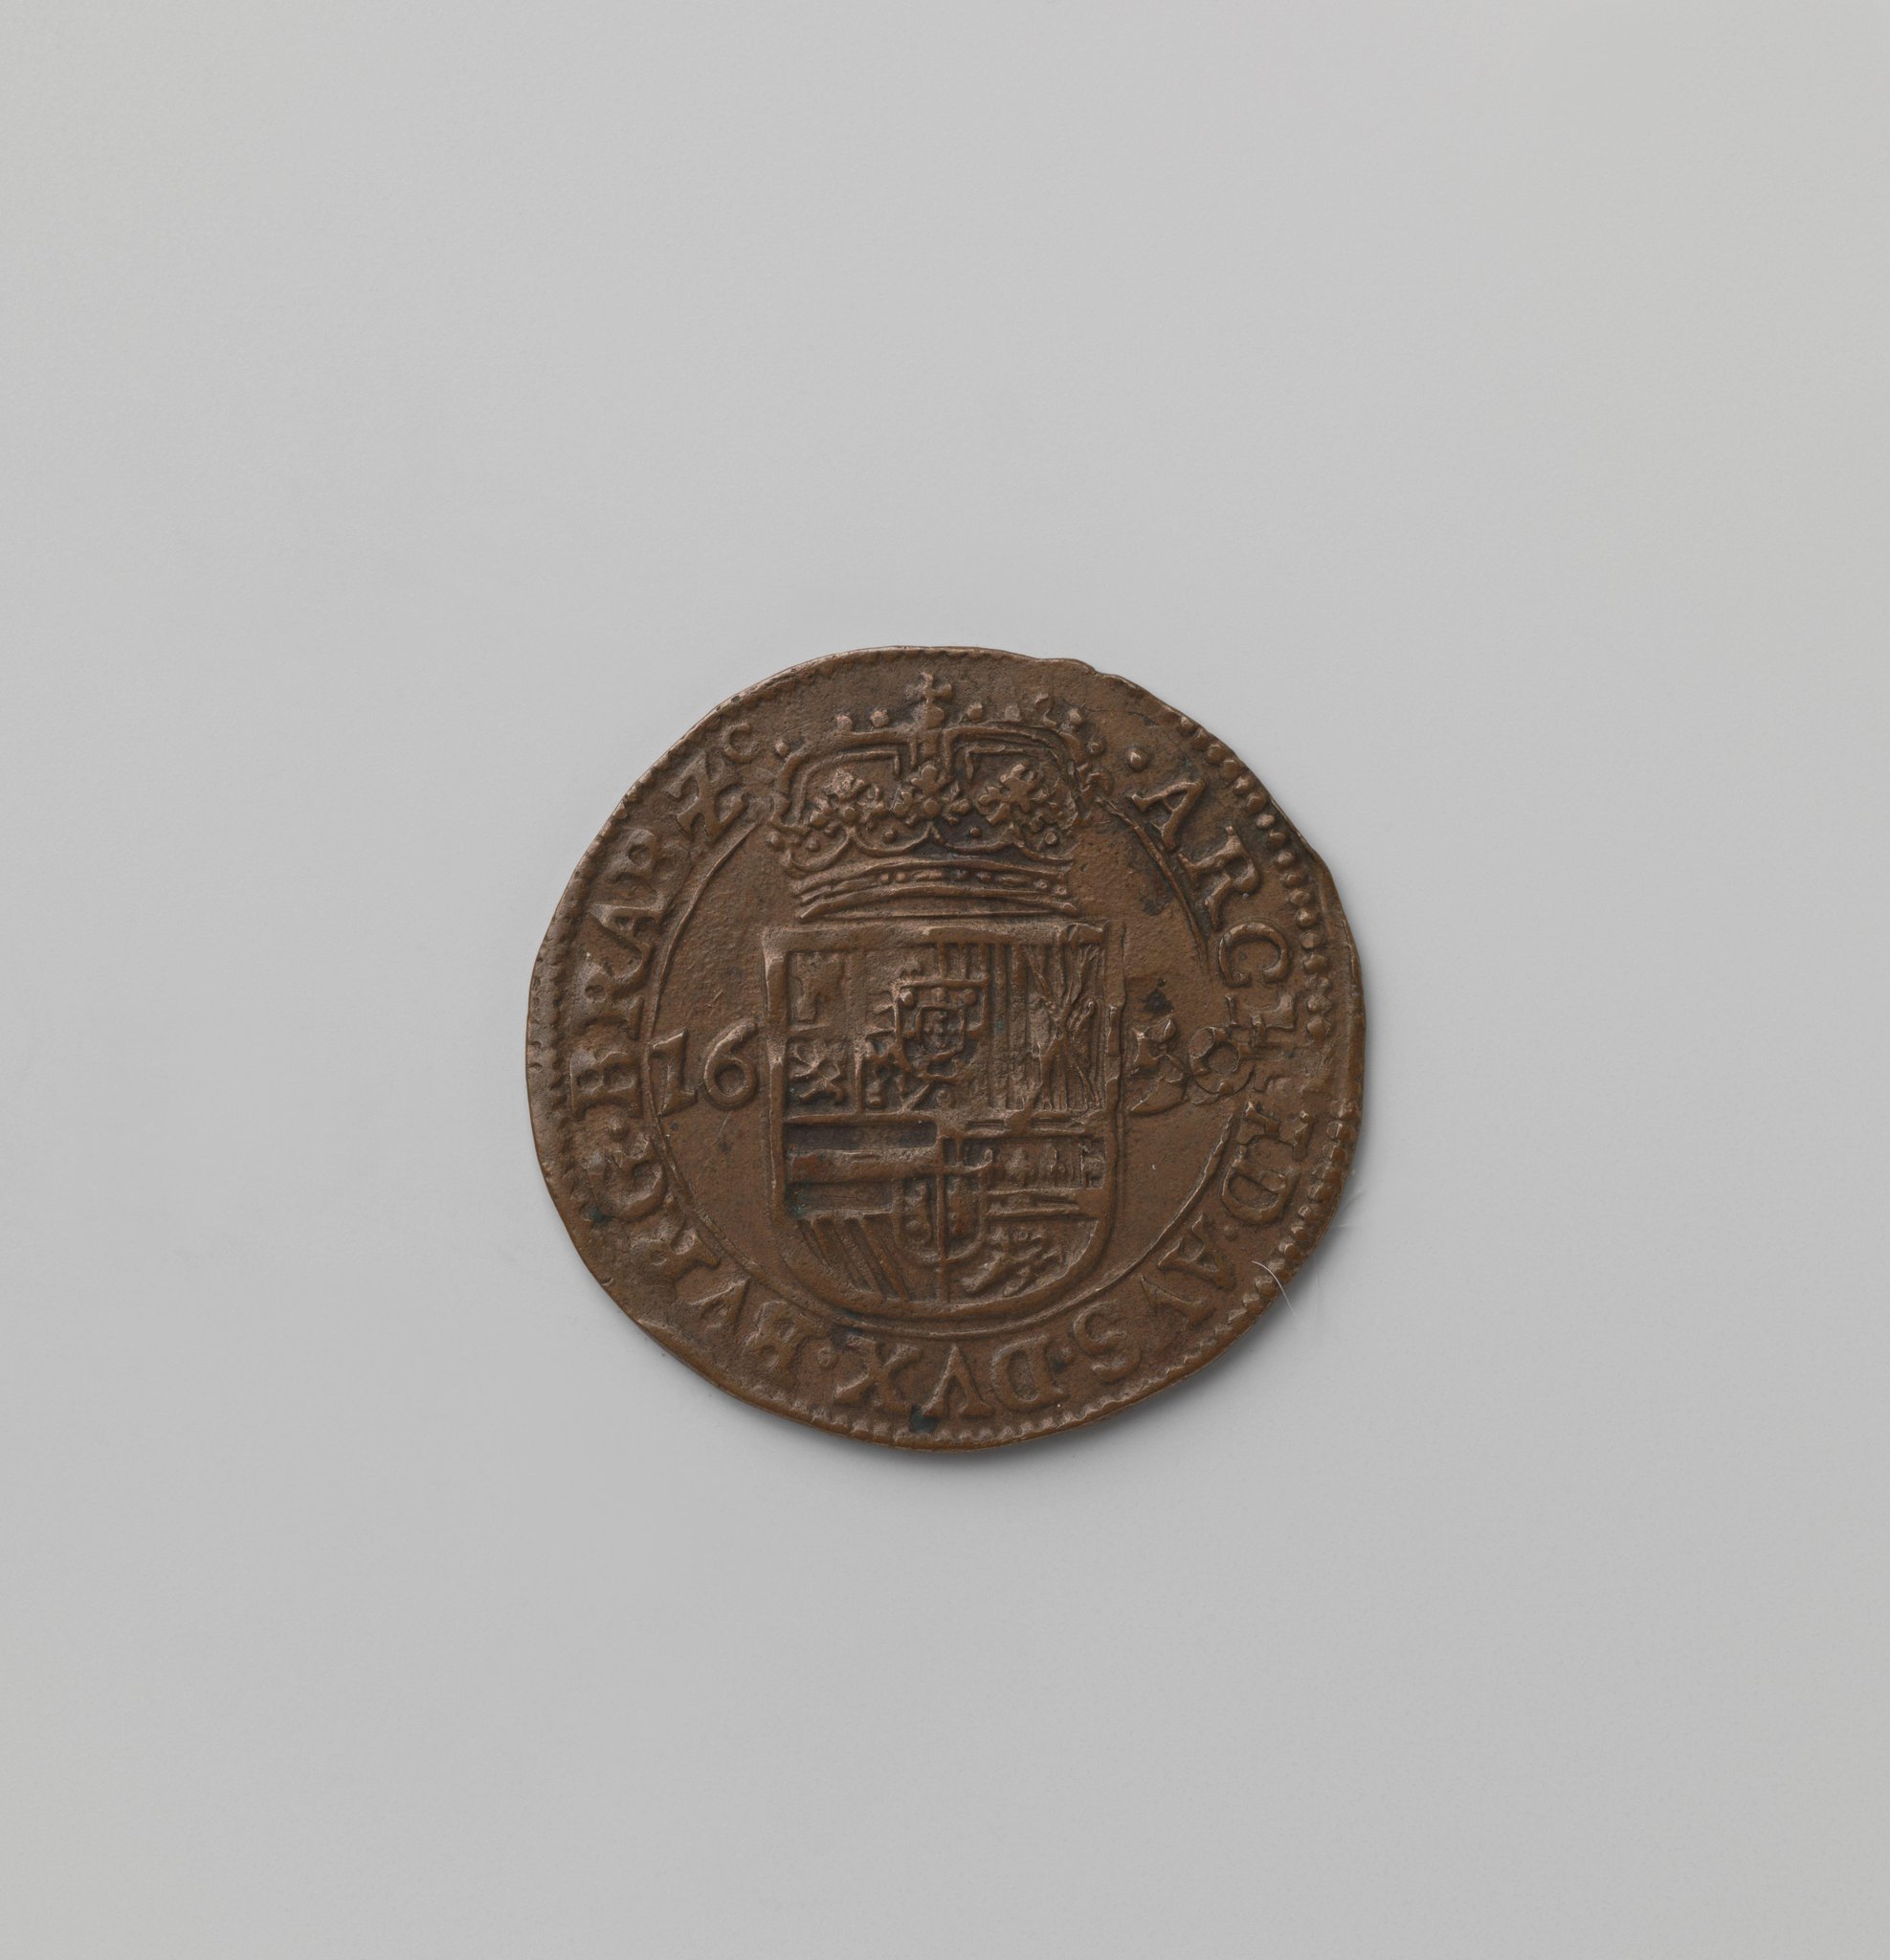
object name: coin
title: Oord uit Brabant van Philips IV, 1650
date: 1650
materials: copper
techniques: striking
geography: brussels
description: Koperen munt. Voorzijde: tussen jaartal gekroond samengesteld wapenschild. Keerzijde: onder kroon vuurijzer. links en rechts daarvan en daaronder wapenschild. Boven kroon engelenkopje.